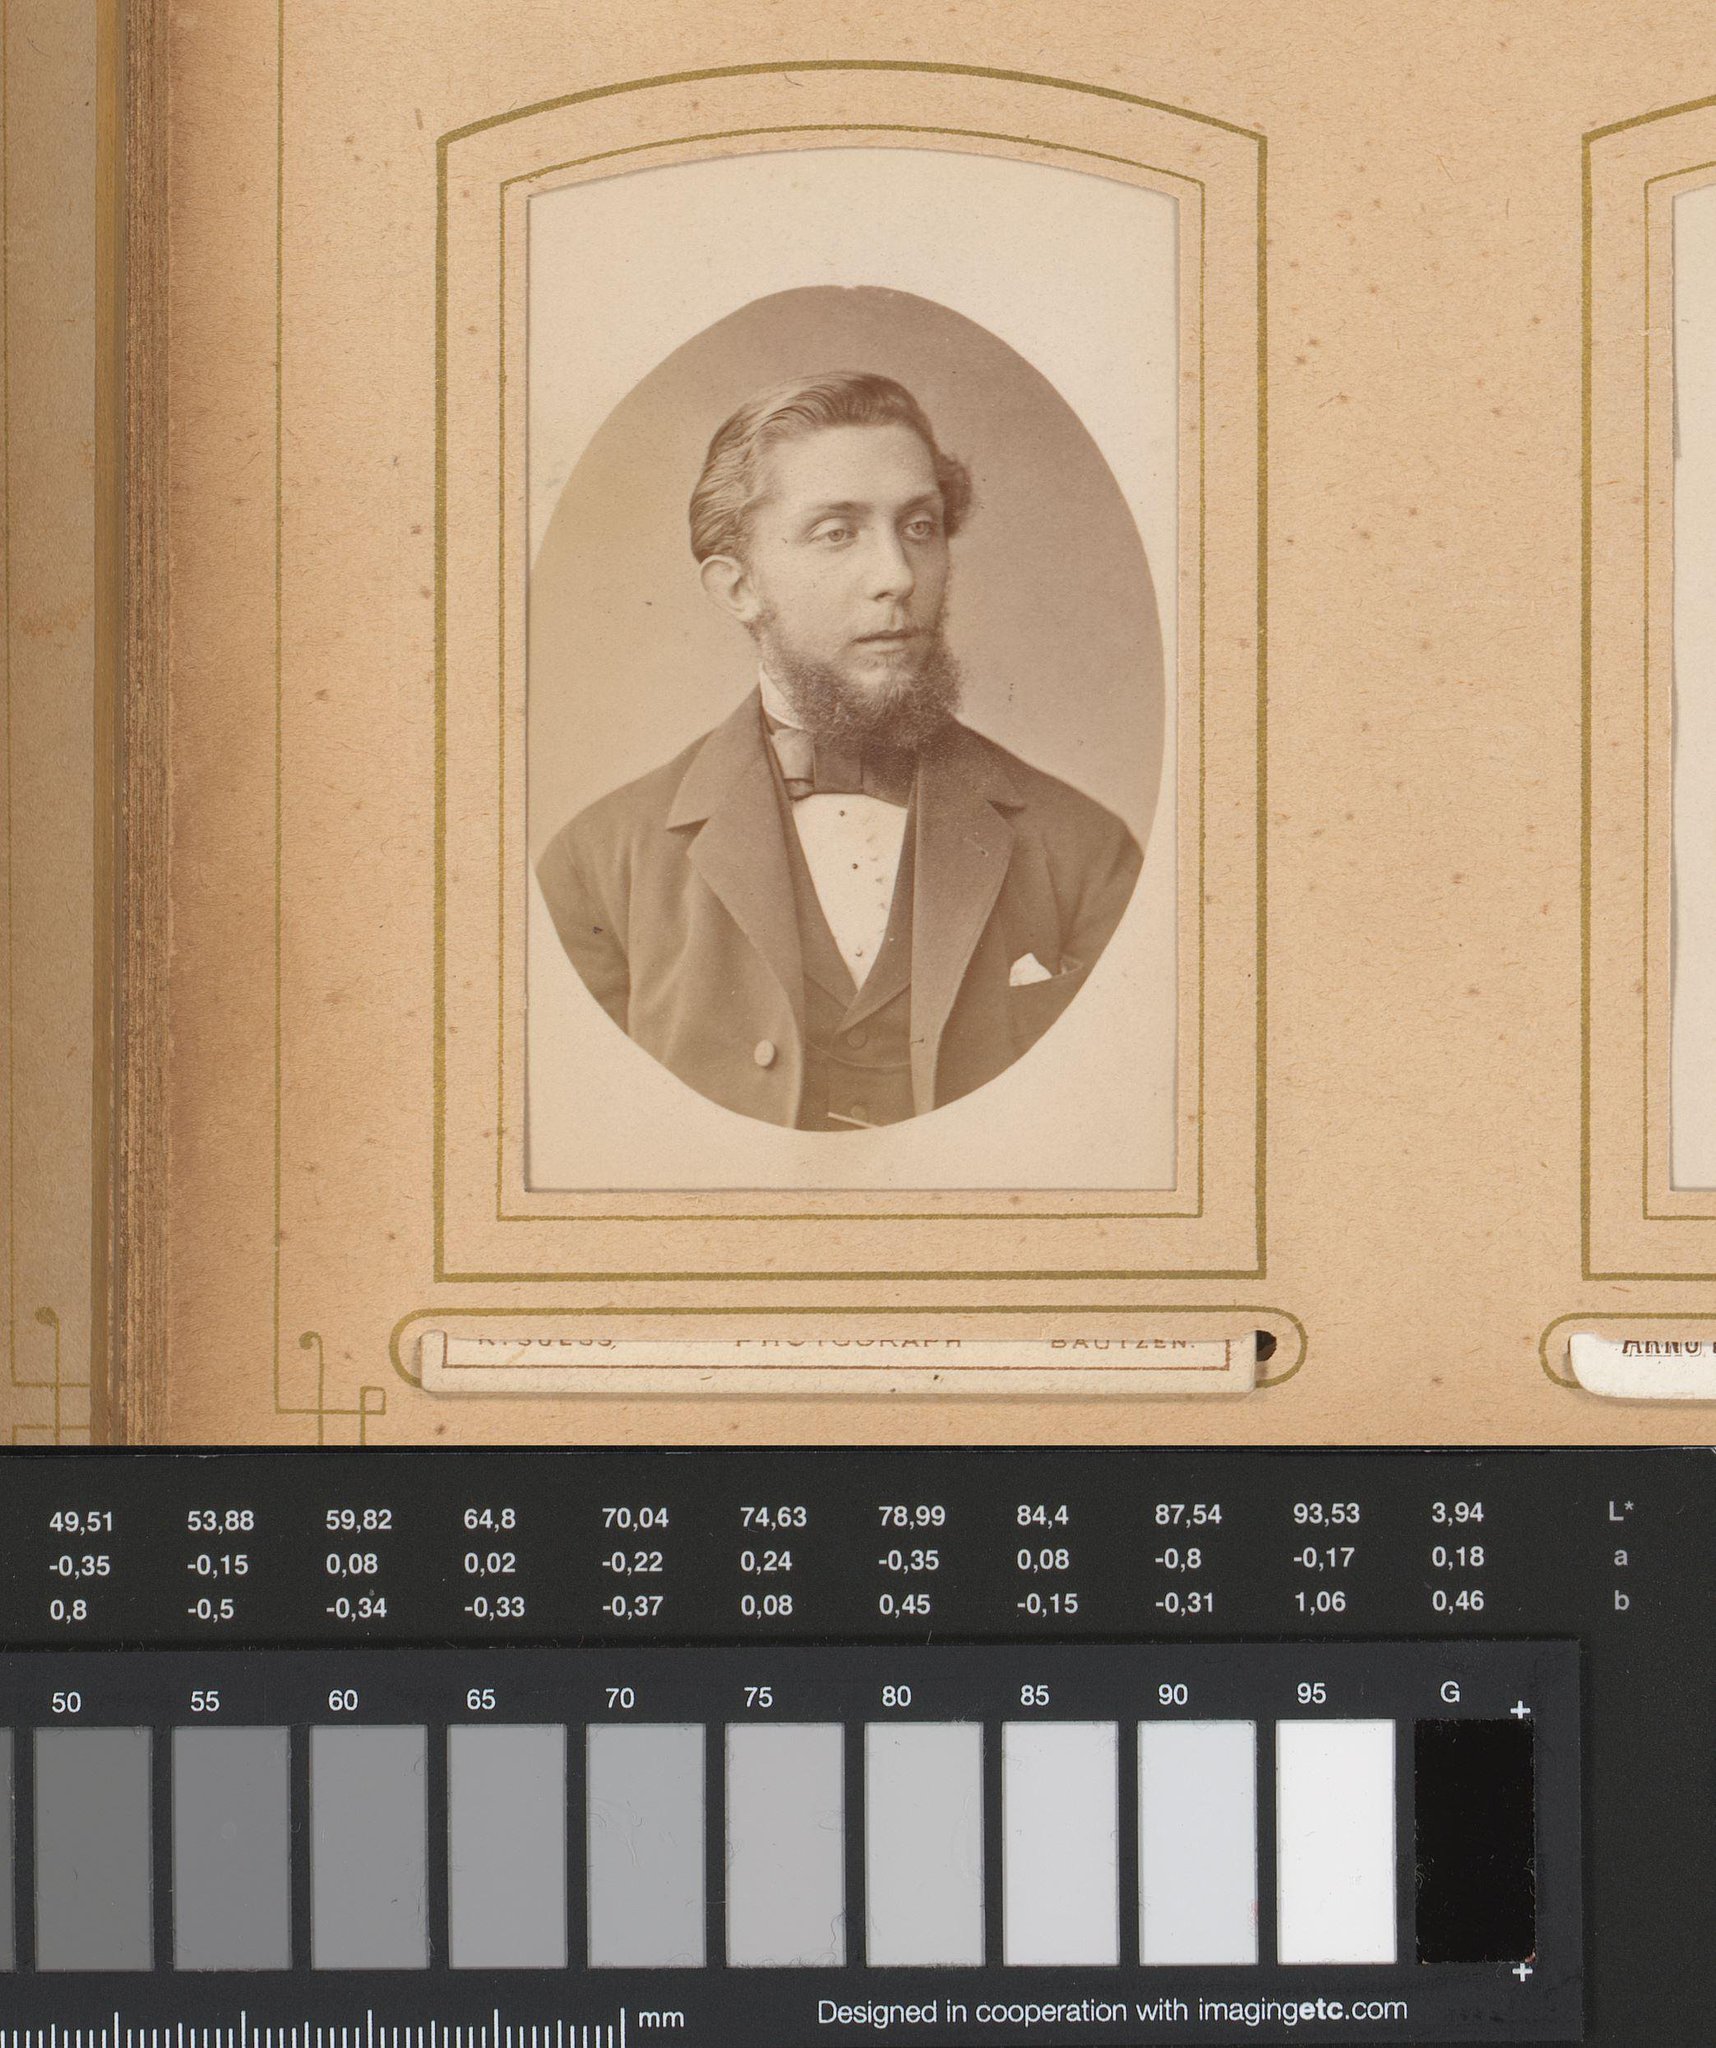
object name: album leaf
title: Portret van een man met baard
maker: robert suess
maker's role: fotograaf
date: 1860-1900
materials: cardboard, photographic support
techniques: albumen print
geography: bautzen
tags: historical persons, beard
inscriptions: inscription: ‘R. Suess/ BAUTZEN/ 668, Tuchmachergasse 668./ Die Platte bleibt zu Nachbestellungen aufbewahrt.’